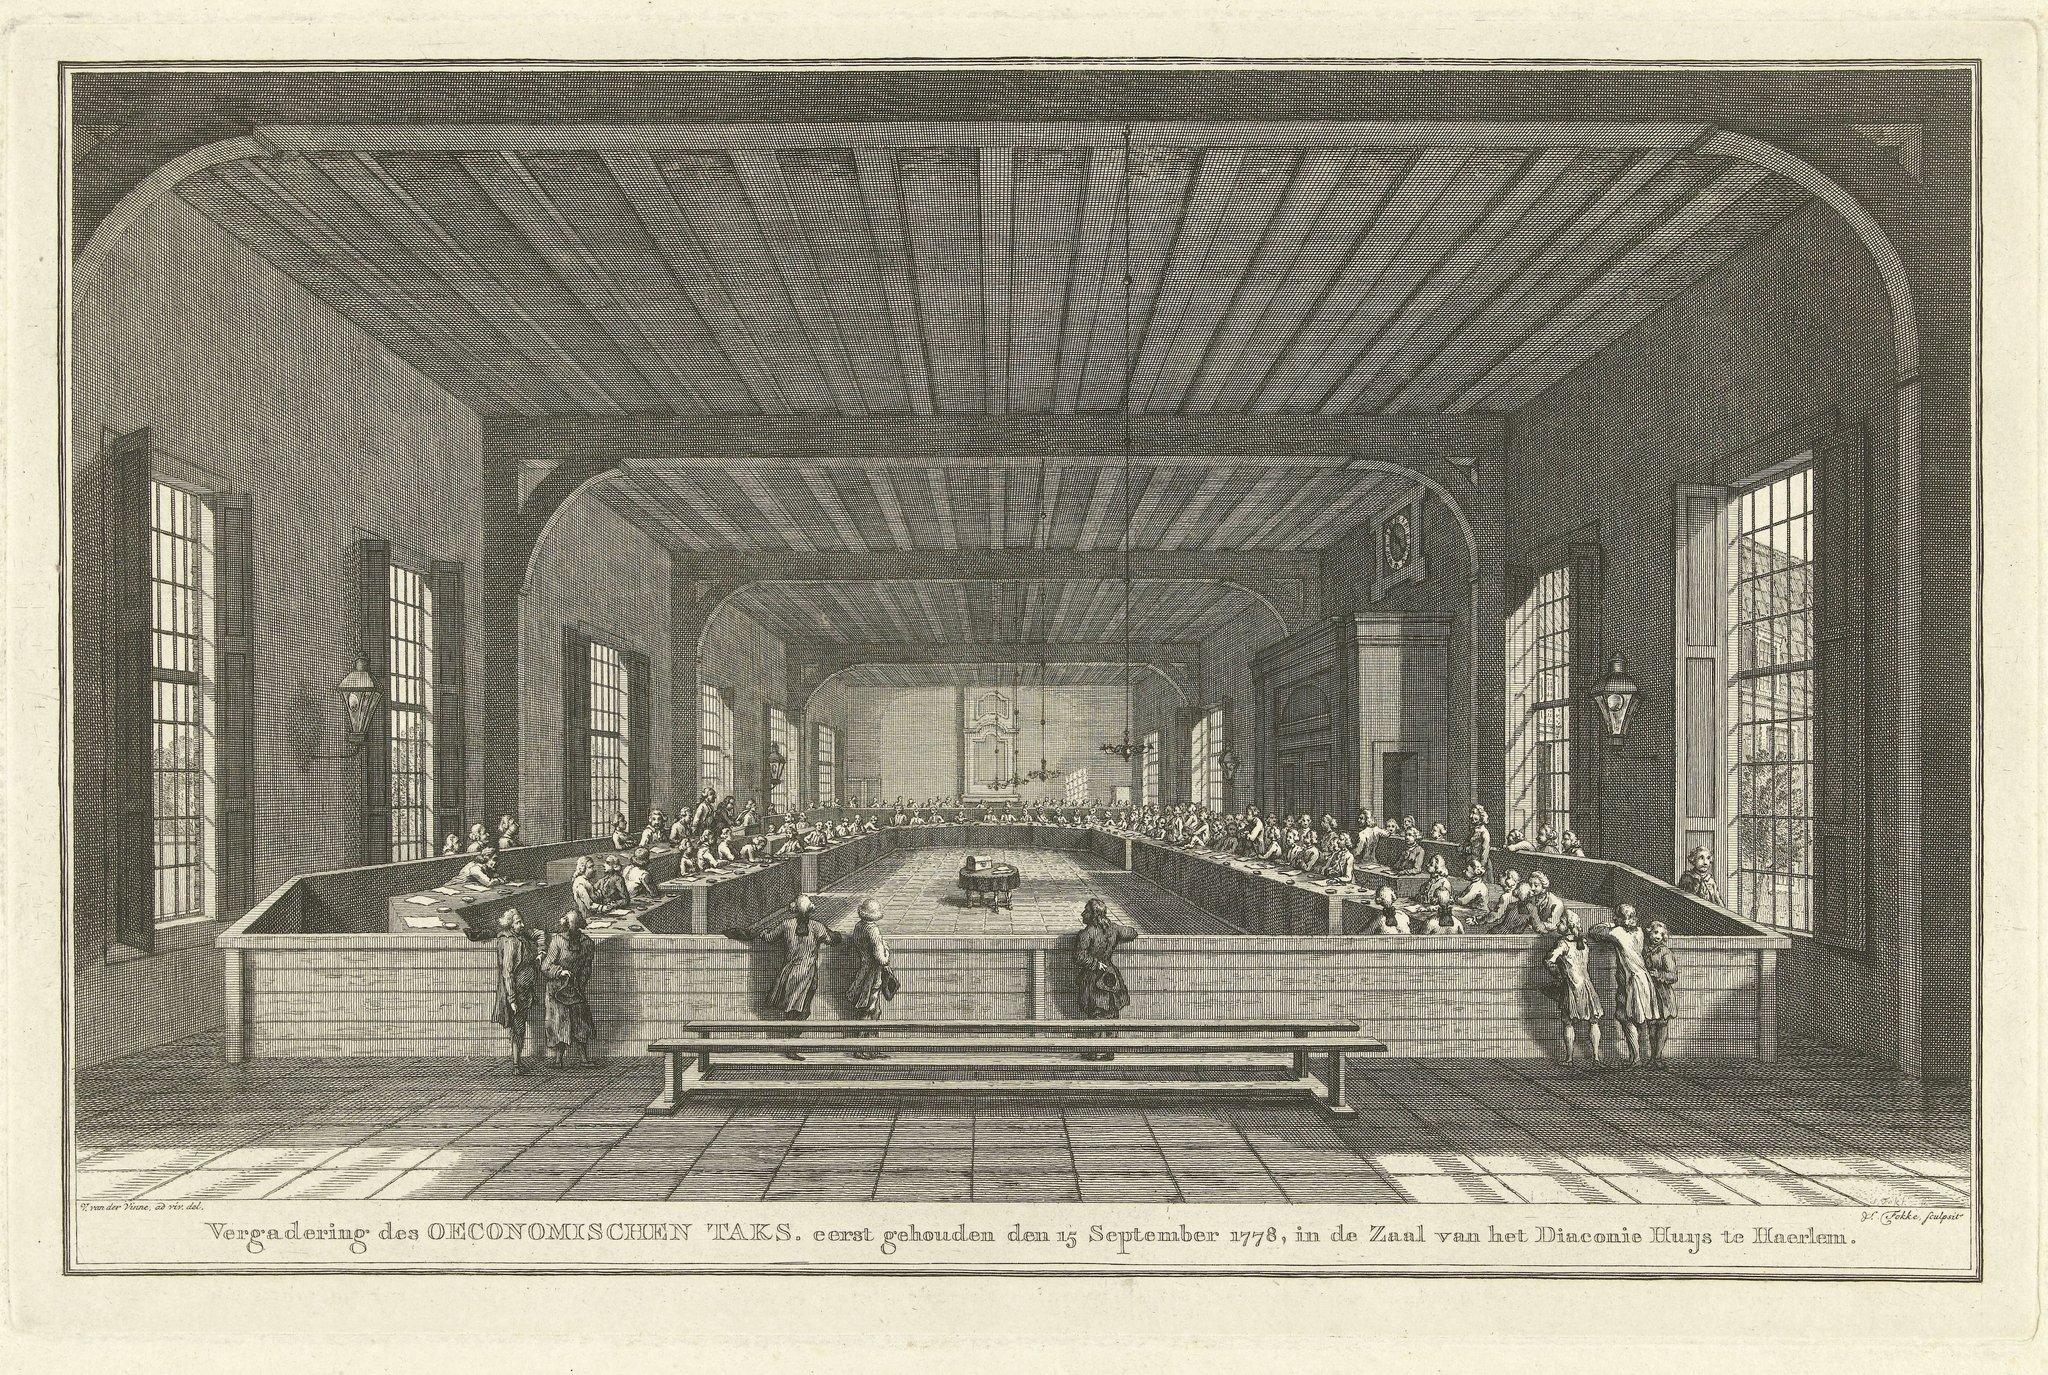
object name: print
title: Vergadering des Oeconomischen Taks. eerst gehouden den 15 september 1778, in de zaal van het Diaconie Huys te Haerlem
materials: paper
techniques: engraving, etching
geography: amsterdam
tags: meeting, assembly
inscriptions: collector's mark: Lugt 2228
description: Gezicht op de eerste vergadering van de Oeconomische Tak, een zelfstandige onderafdeling van de Hollandsche Maatschappij der Wetenschappen, gehouden op 15 september 1778 in de eetzaal van het Diaconiehuis te Haarlem.